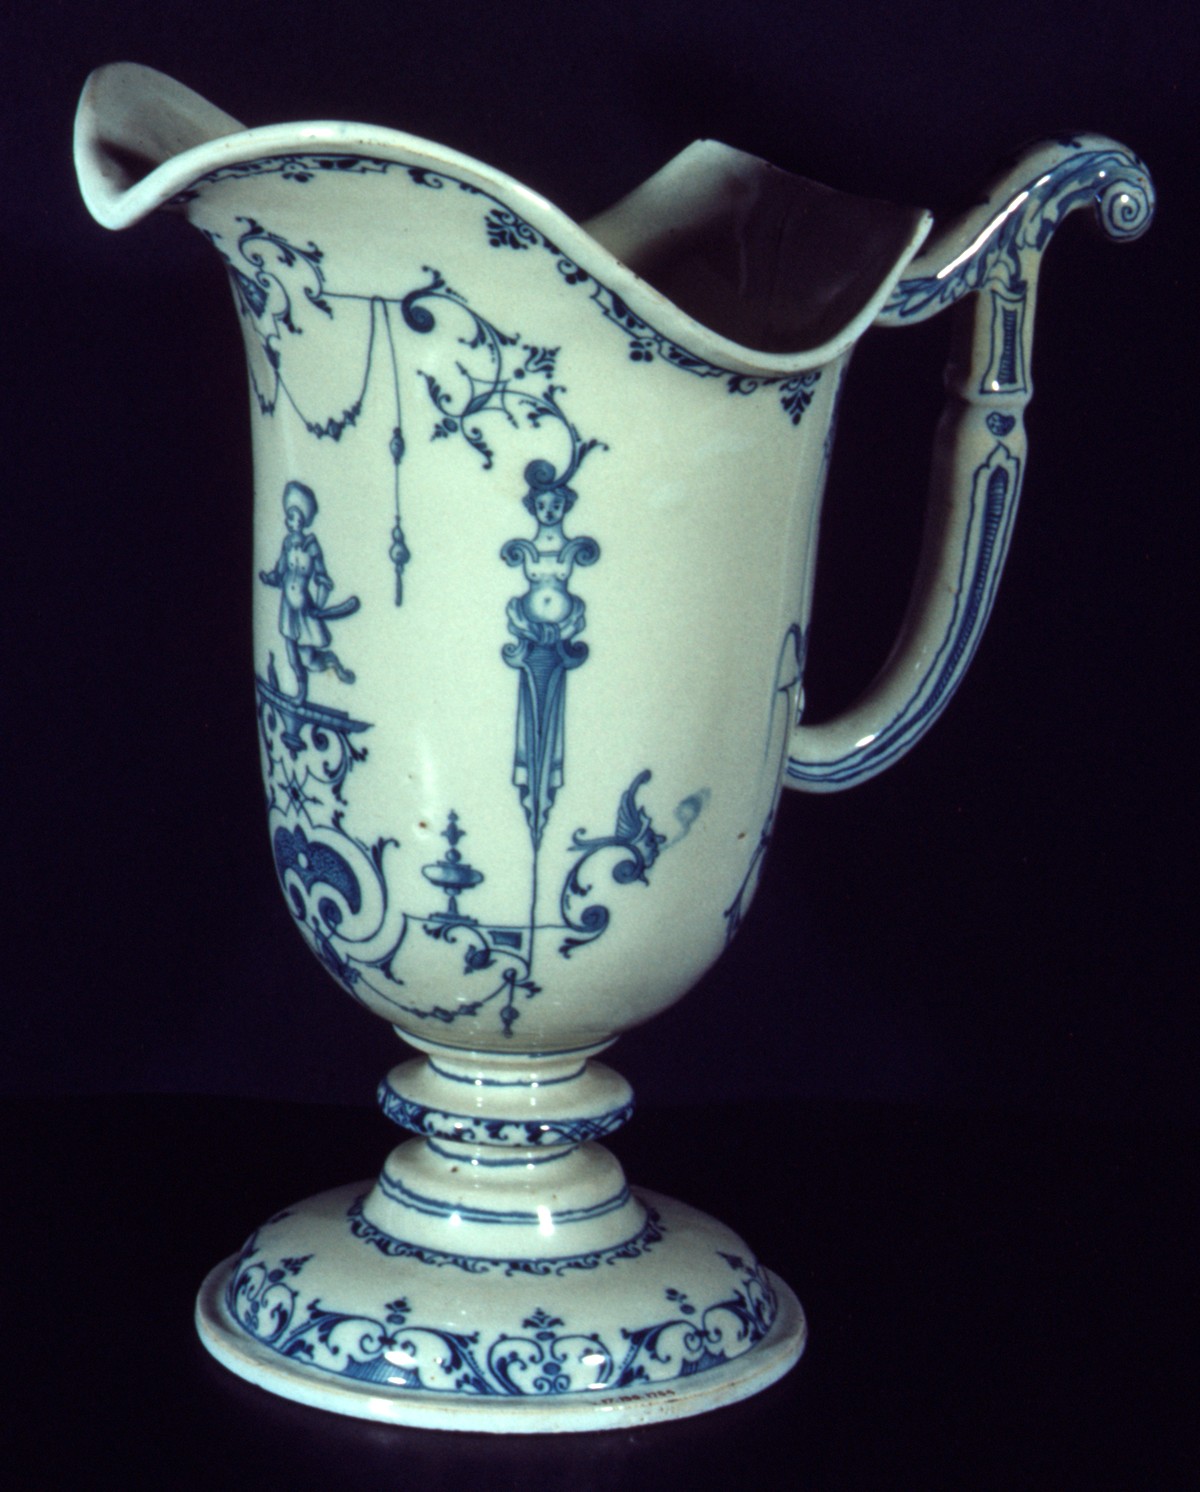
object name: ewer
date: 1710-1720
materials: faience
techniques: glazing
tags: men